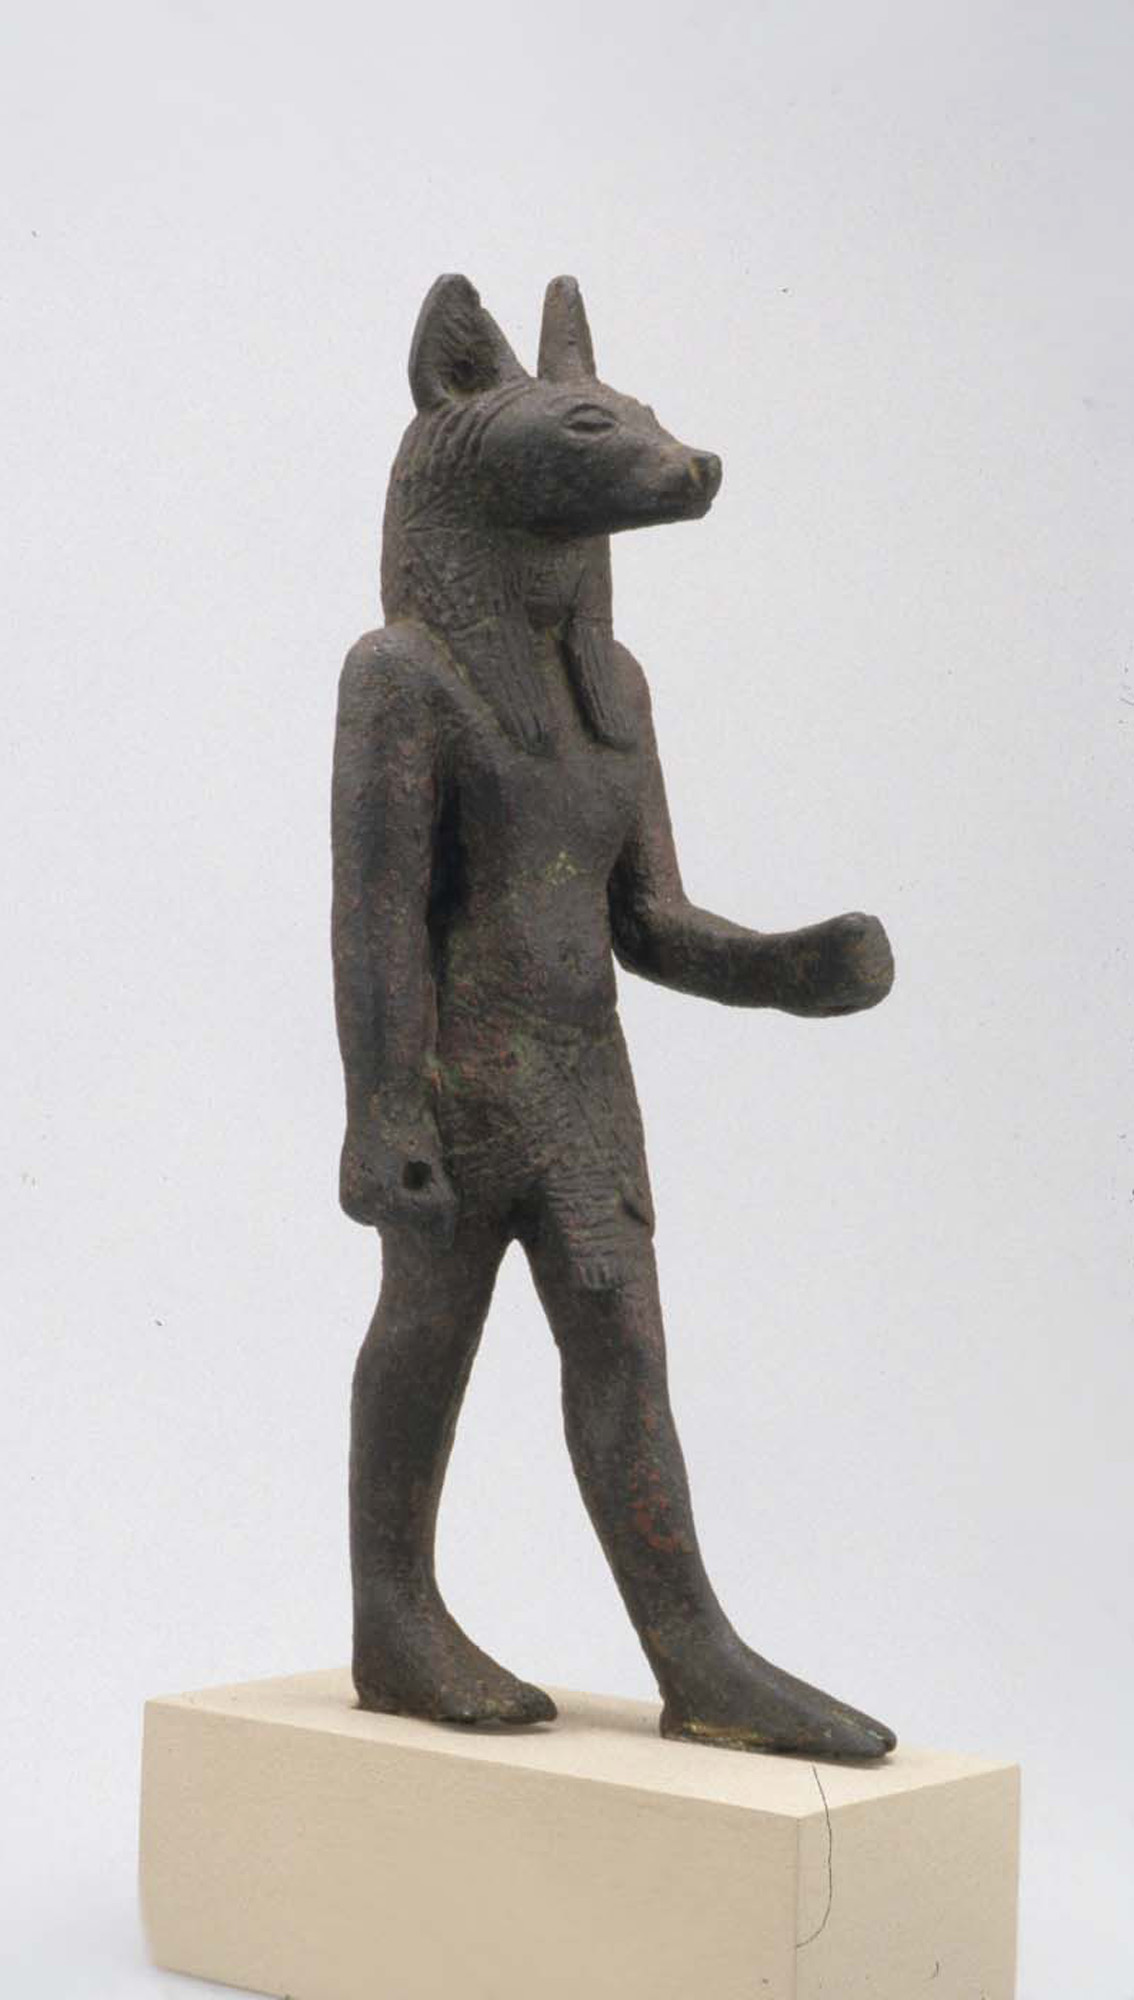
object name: statuette, anubis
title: Anubis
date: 664-630 BCE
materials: metal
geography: egypt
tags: anubis